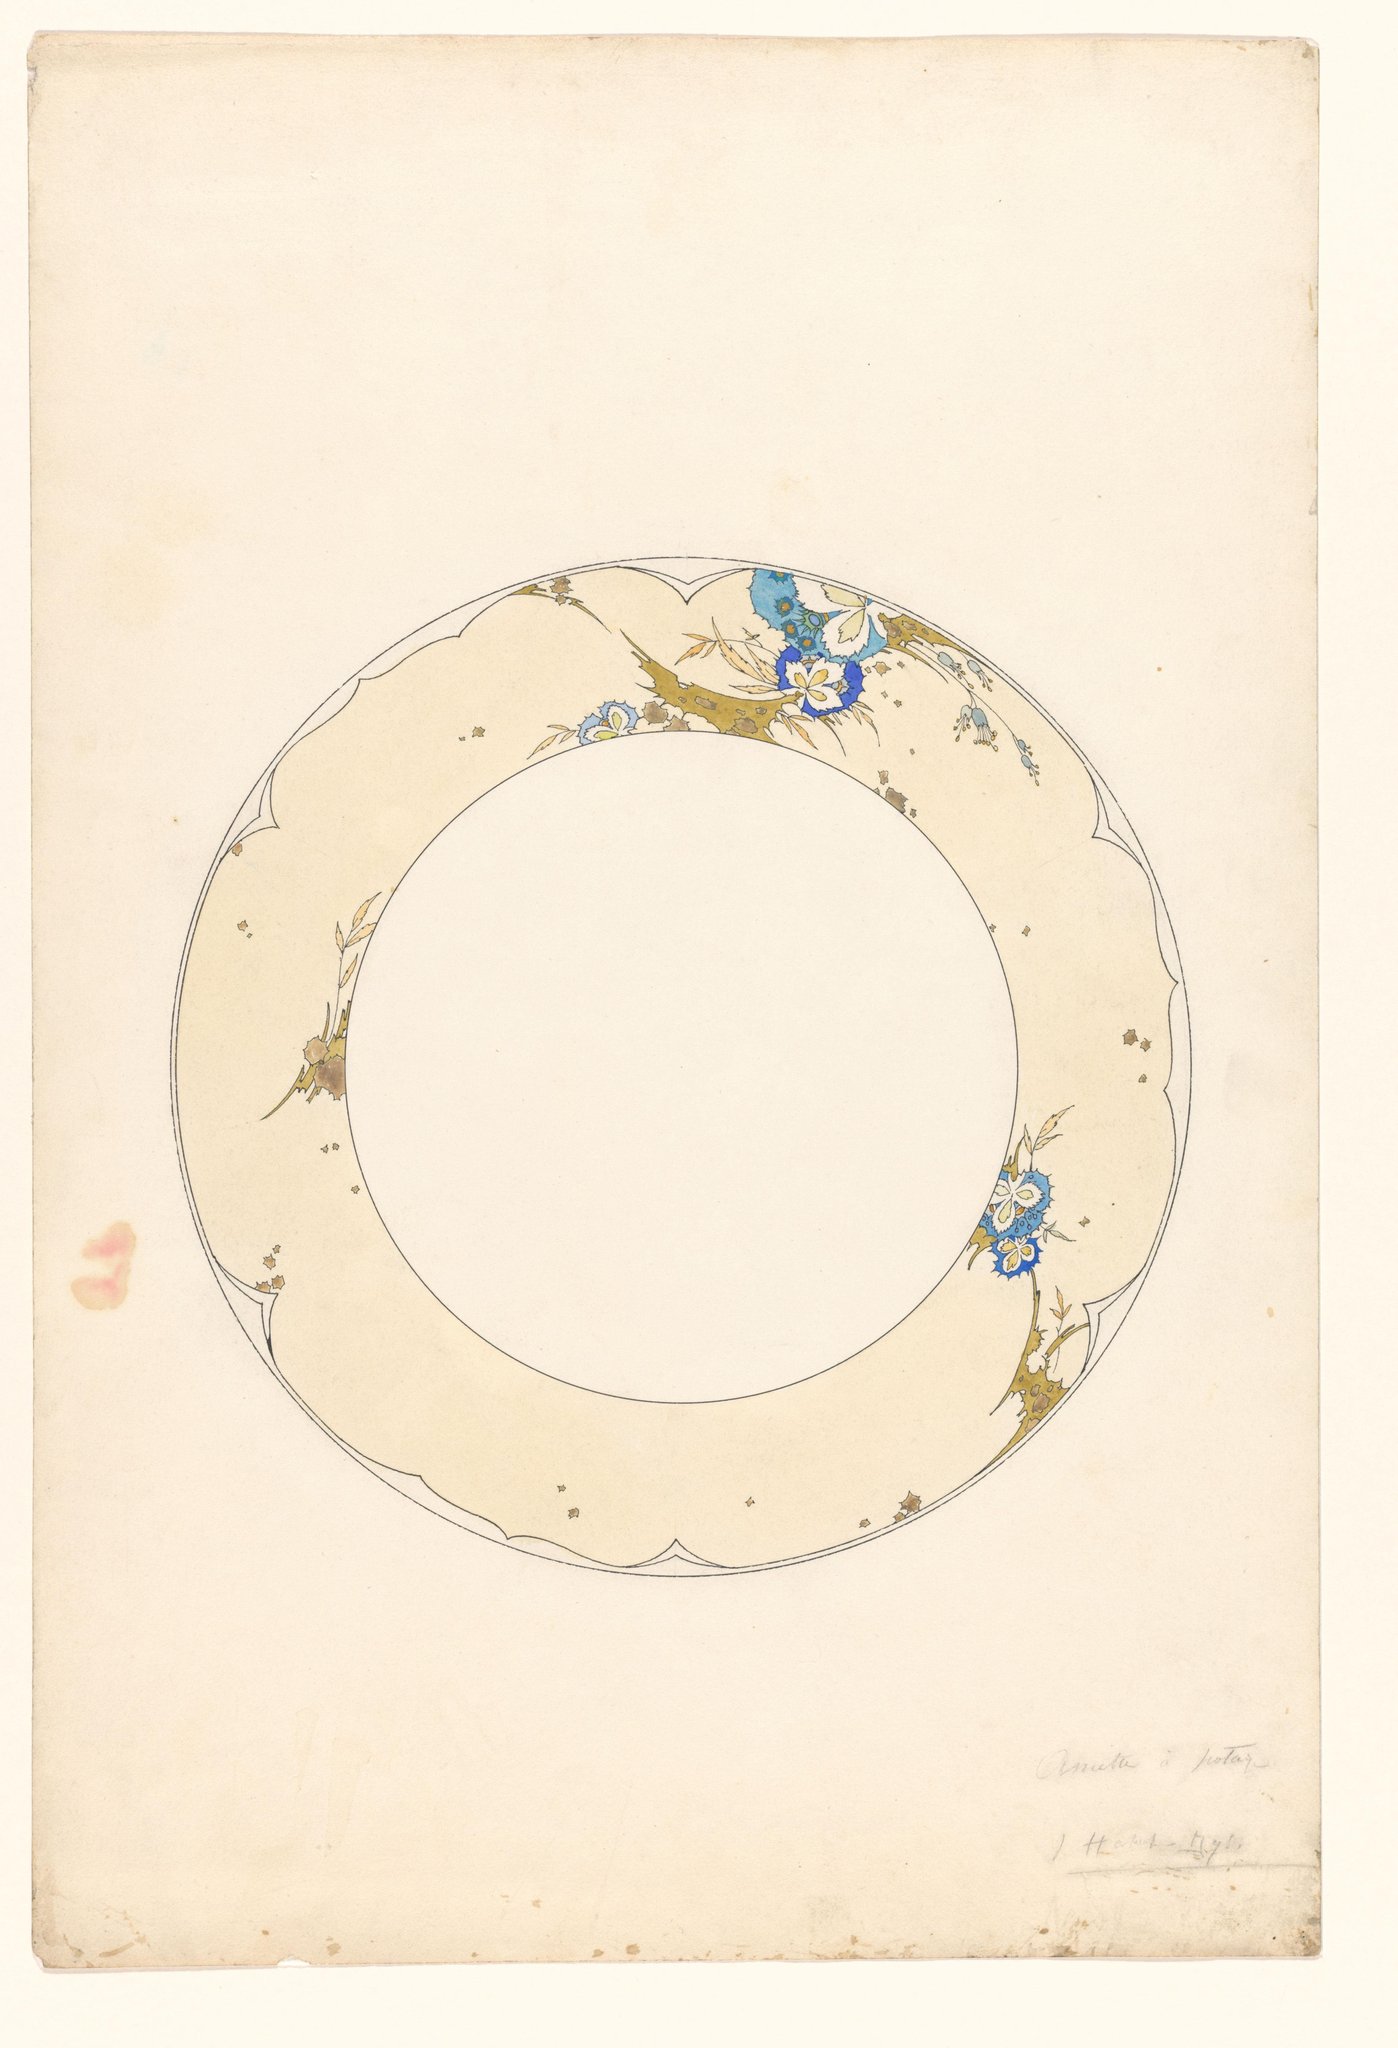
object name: drawing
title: Tien ontwerptekeningen voor een porseleinen servies voor Pillivuyt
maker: jules auguste habert-dys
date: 1889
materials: ink, paper, watercolor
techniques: brush, pen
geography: sèvres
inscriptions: signature: ‘J Habert-Dys’, inscription: ‘Assiette à potage’